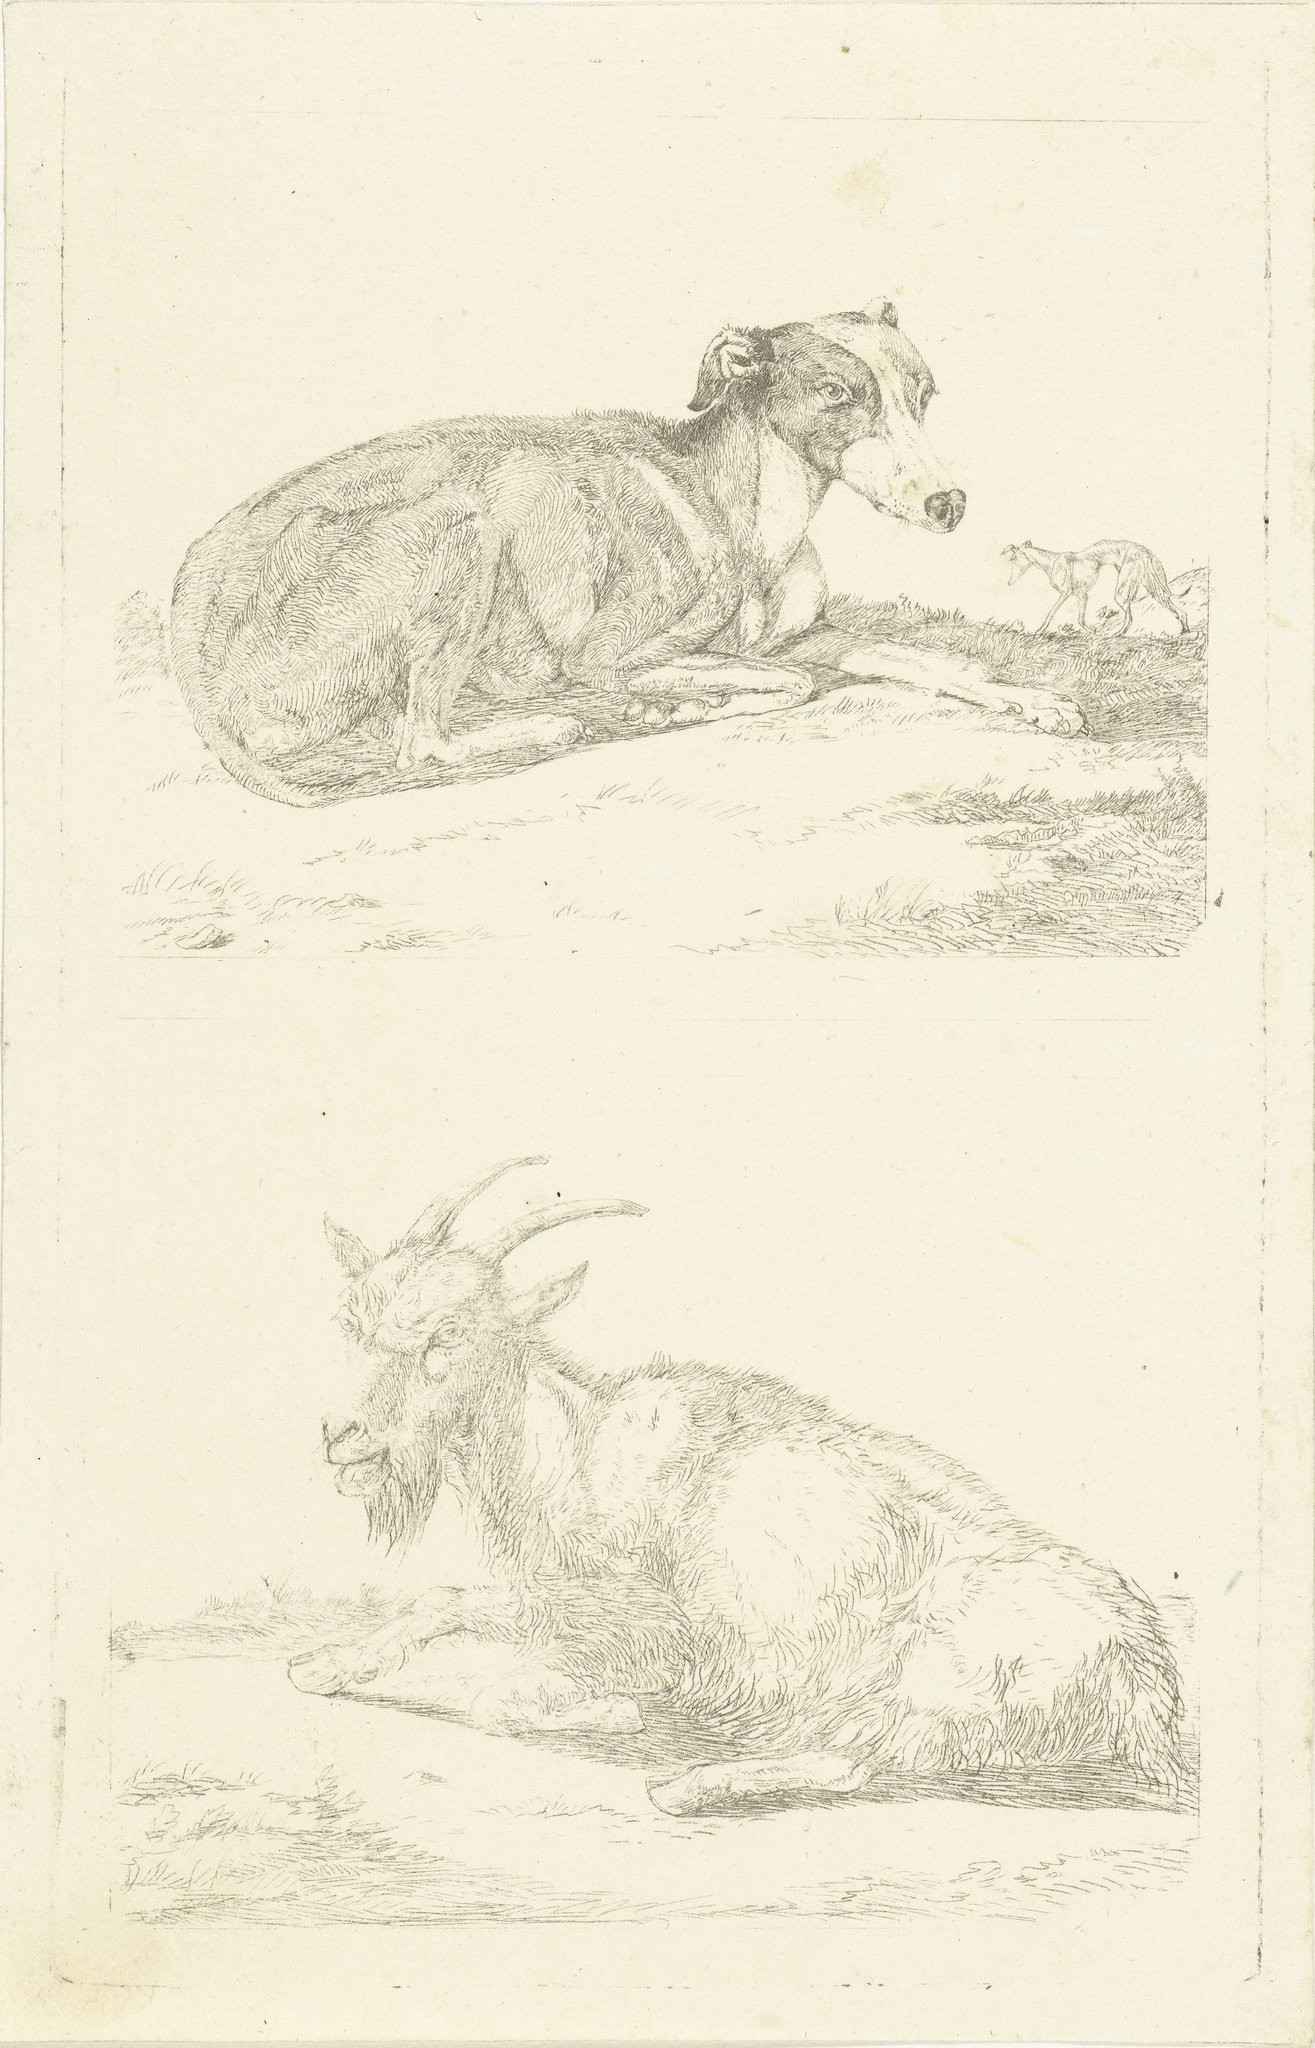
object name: print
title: Hazewindhonden en geit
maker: jan dasveldt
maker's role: draughtsman, print maker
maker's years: 1770-1855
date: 1780-1855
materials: paper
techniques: printmaking, etching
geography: amsterdam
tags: goat, dog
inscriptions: collector's mark: Lugt 1962, collector's mark: Lugt 2228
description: Vergelijk de ets waarvan deze tegenafdruk gemaakt werd in de collectie van het RMA, inv.nr. RP-P-1882-A-4996.